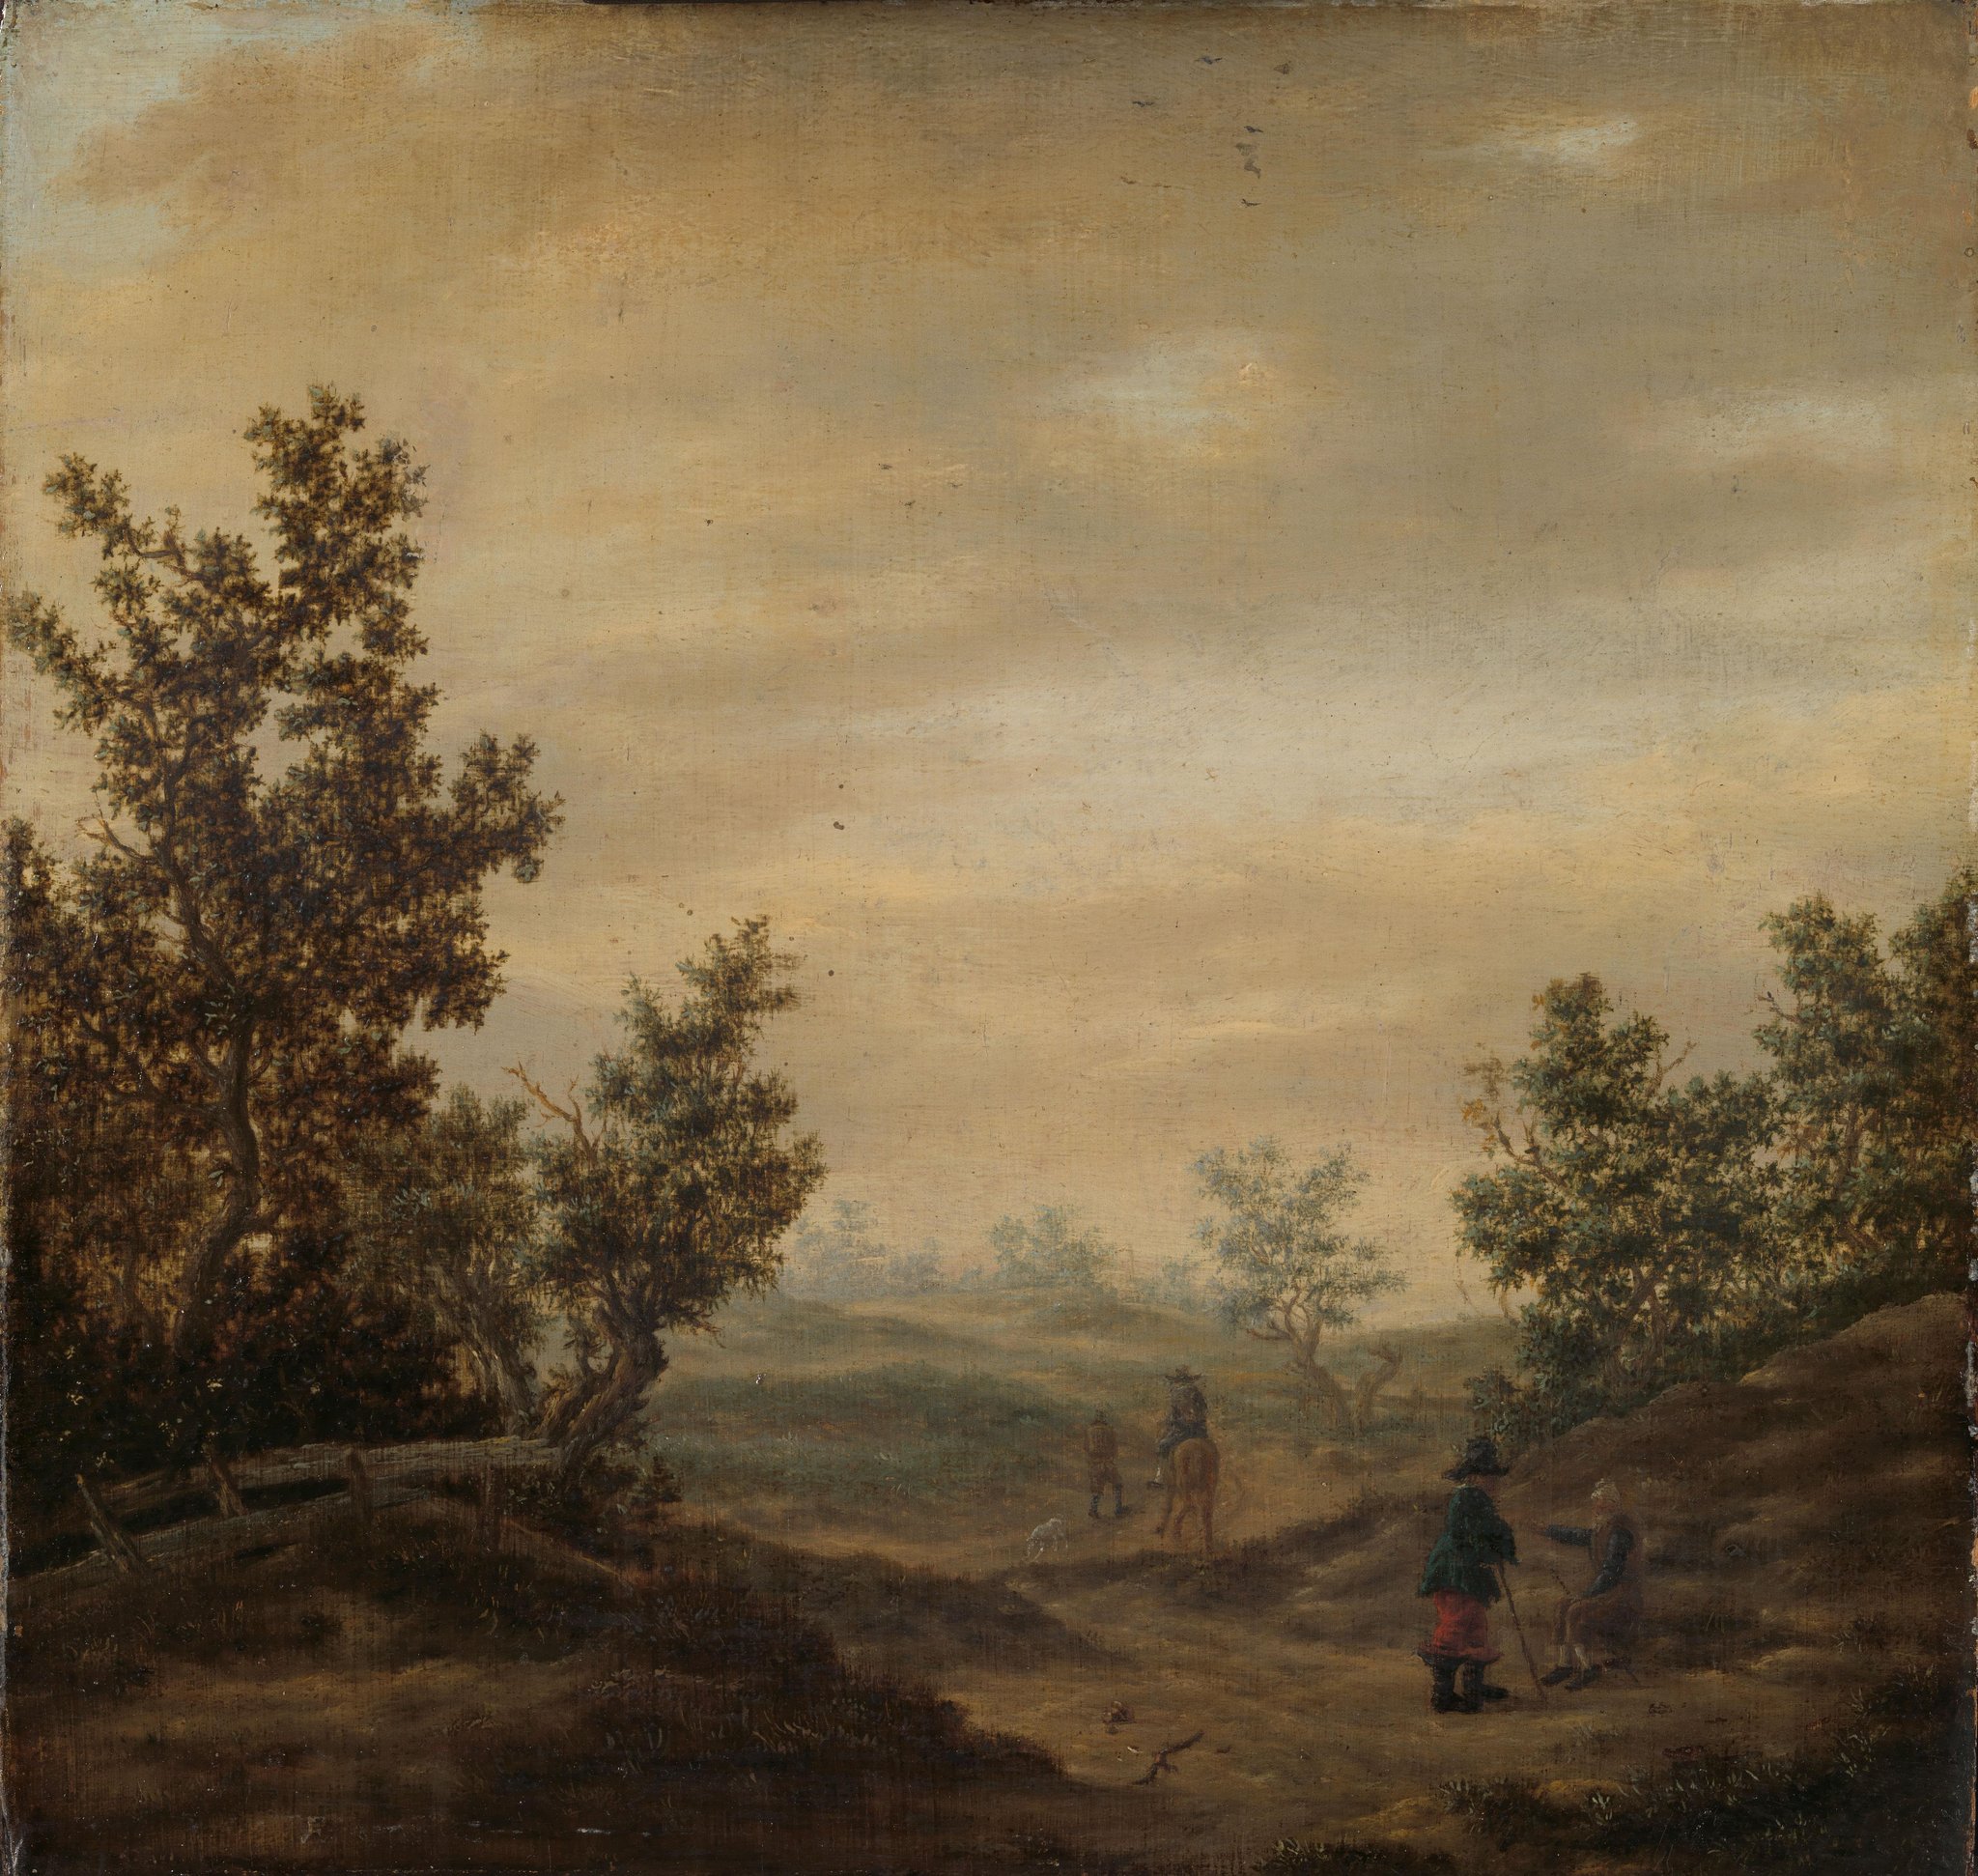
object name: painting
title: Road in the Dunes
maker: claes van beresteyn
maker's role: draughtsman, print maker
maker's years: 1627-1684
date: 1629-1684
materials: oil, panel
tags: dunes (sea not visible); in the dunes, road, path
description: Duinlandschap met verschillende figuren onderweg of rustend.